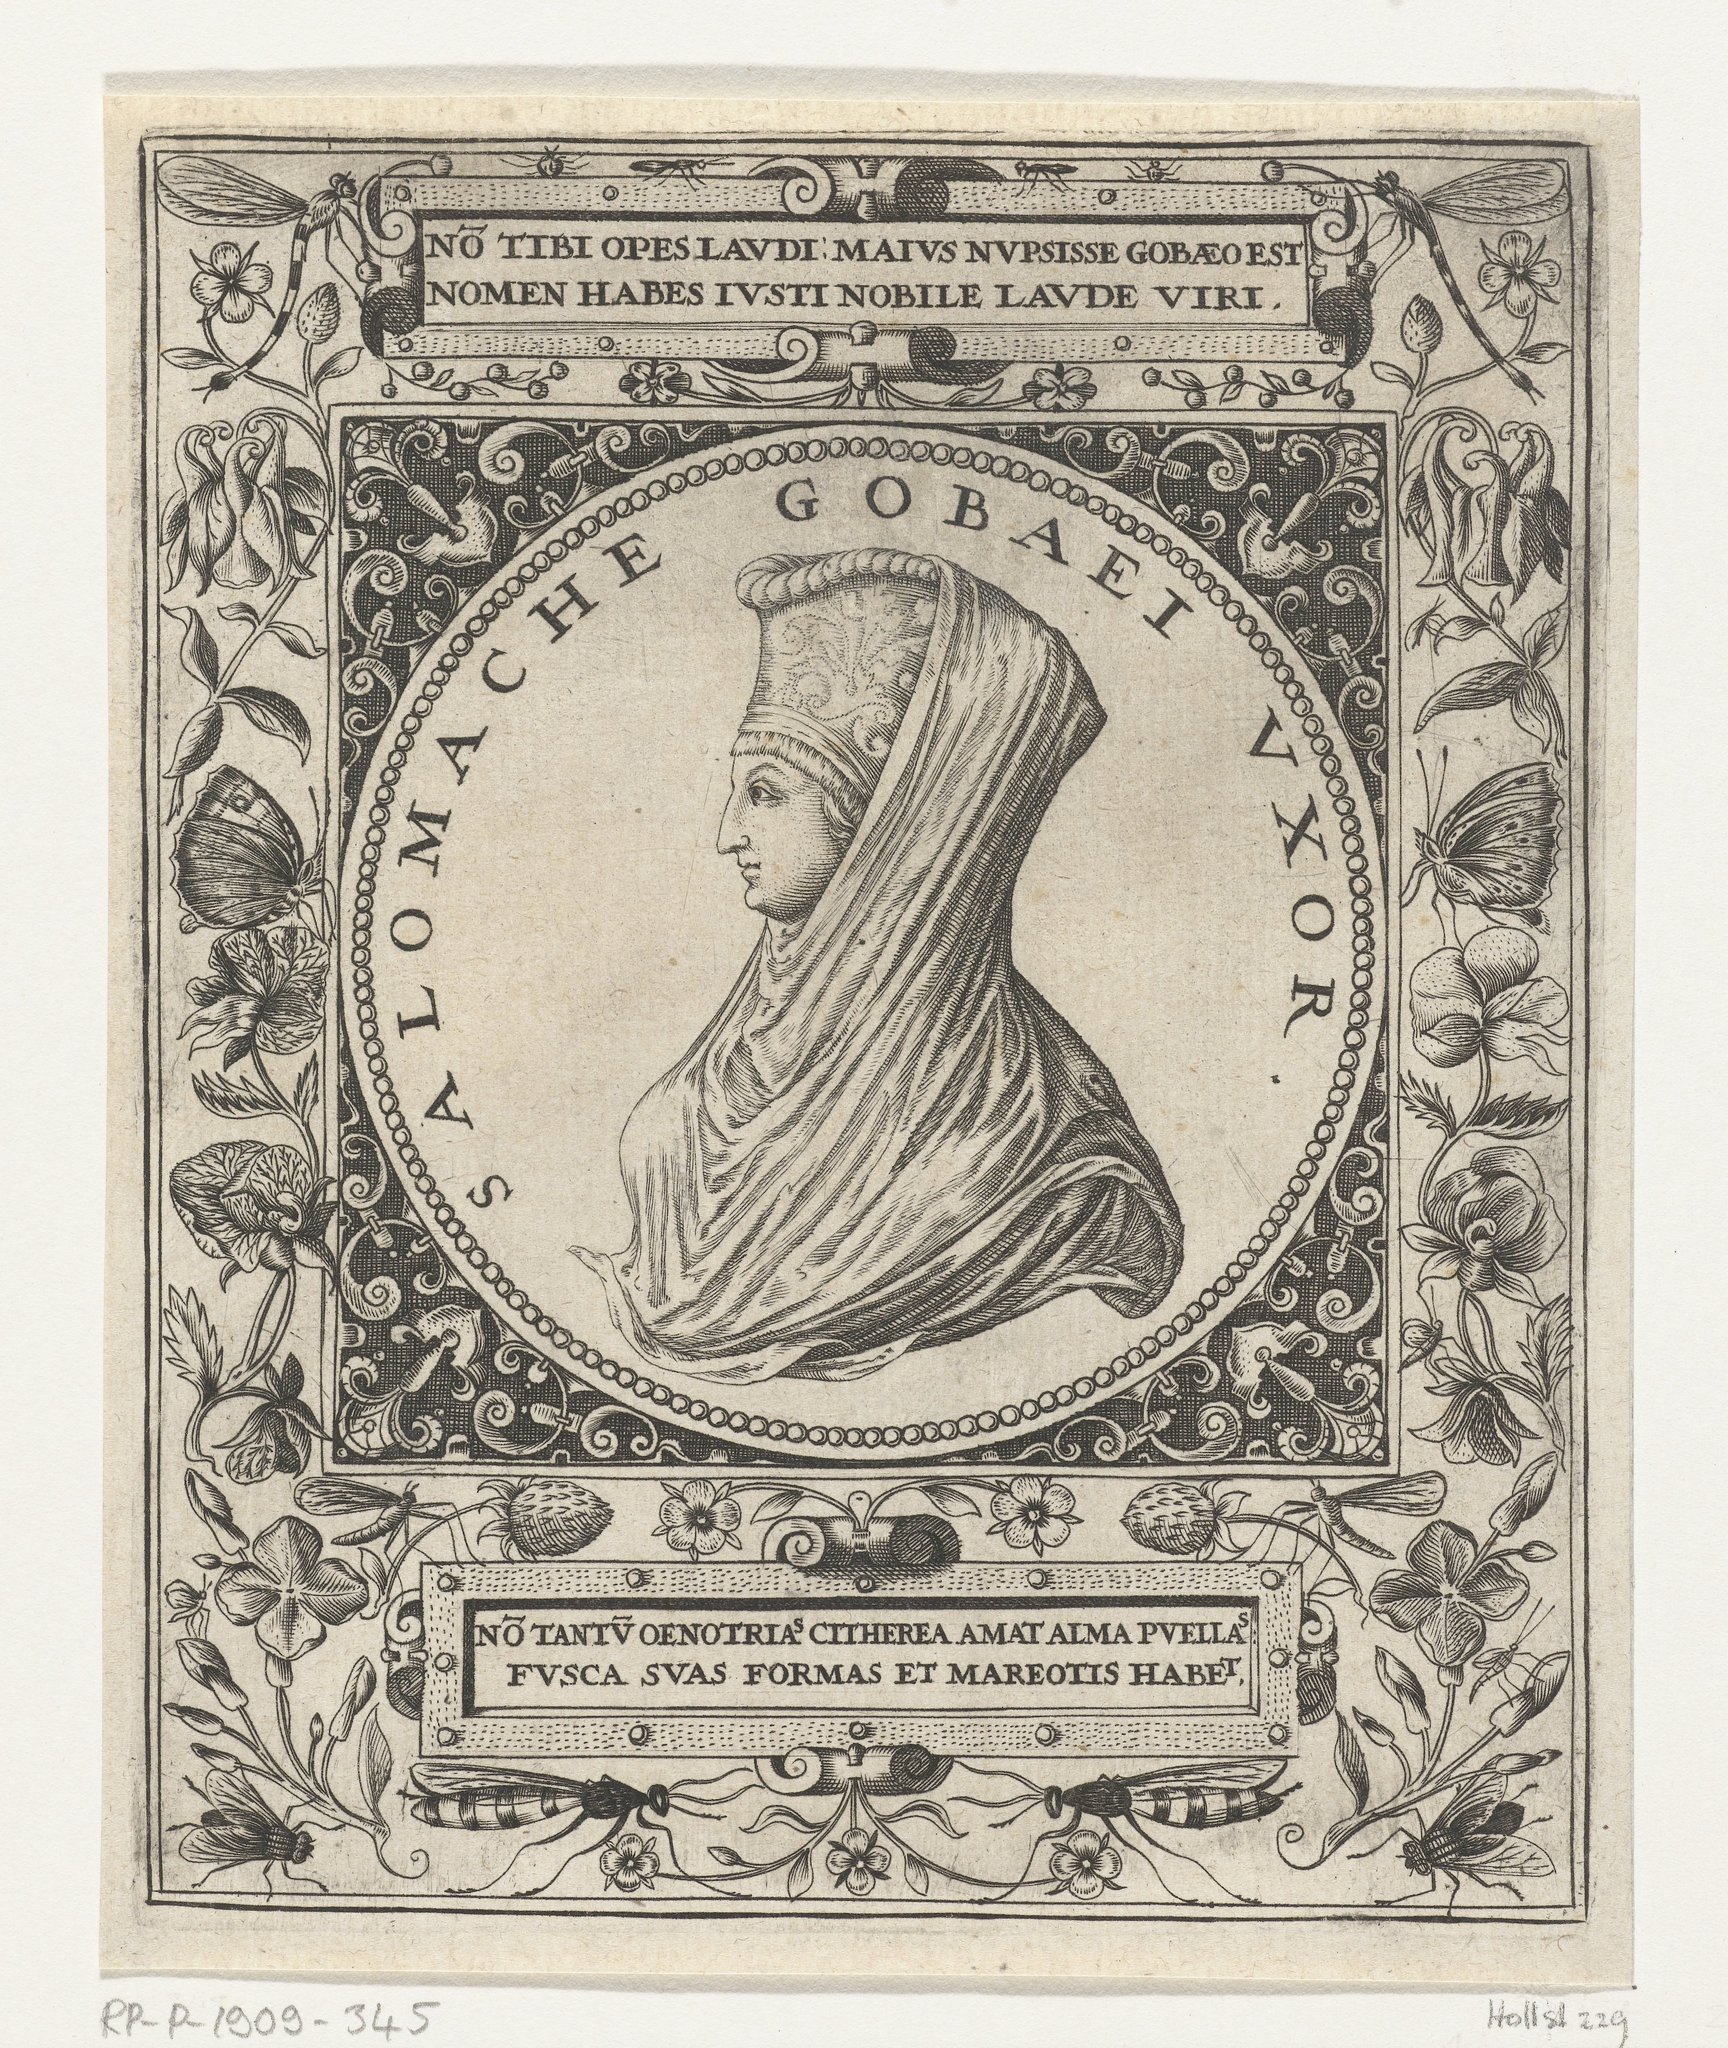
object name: book illustration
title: Salomache Gobaei Uxor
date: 1596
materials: paper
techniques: engraving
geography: frankfurt am main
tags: islam, mohammedanism, ruler, sovereign - bb - female ruler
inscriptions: collector's mark: Lugt 2228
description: Afkomstig uit: J.J. Boissard, Vitae et icones svltanorvm tvrcicorum, principvm persarvm aliorumq illustrium heroum heroinarumq ab Osmane usq ad Mahometem II. Frankfurt am Main: T. de Bry, 1596.